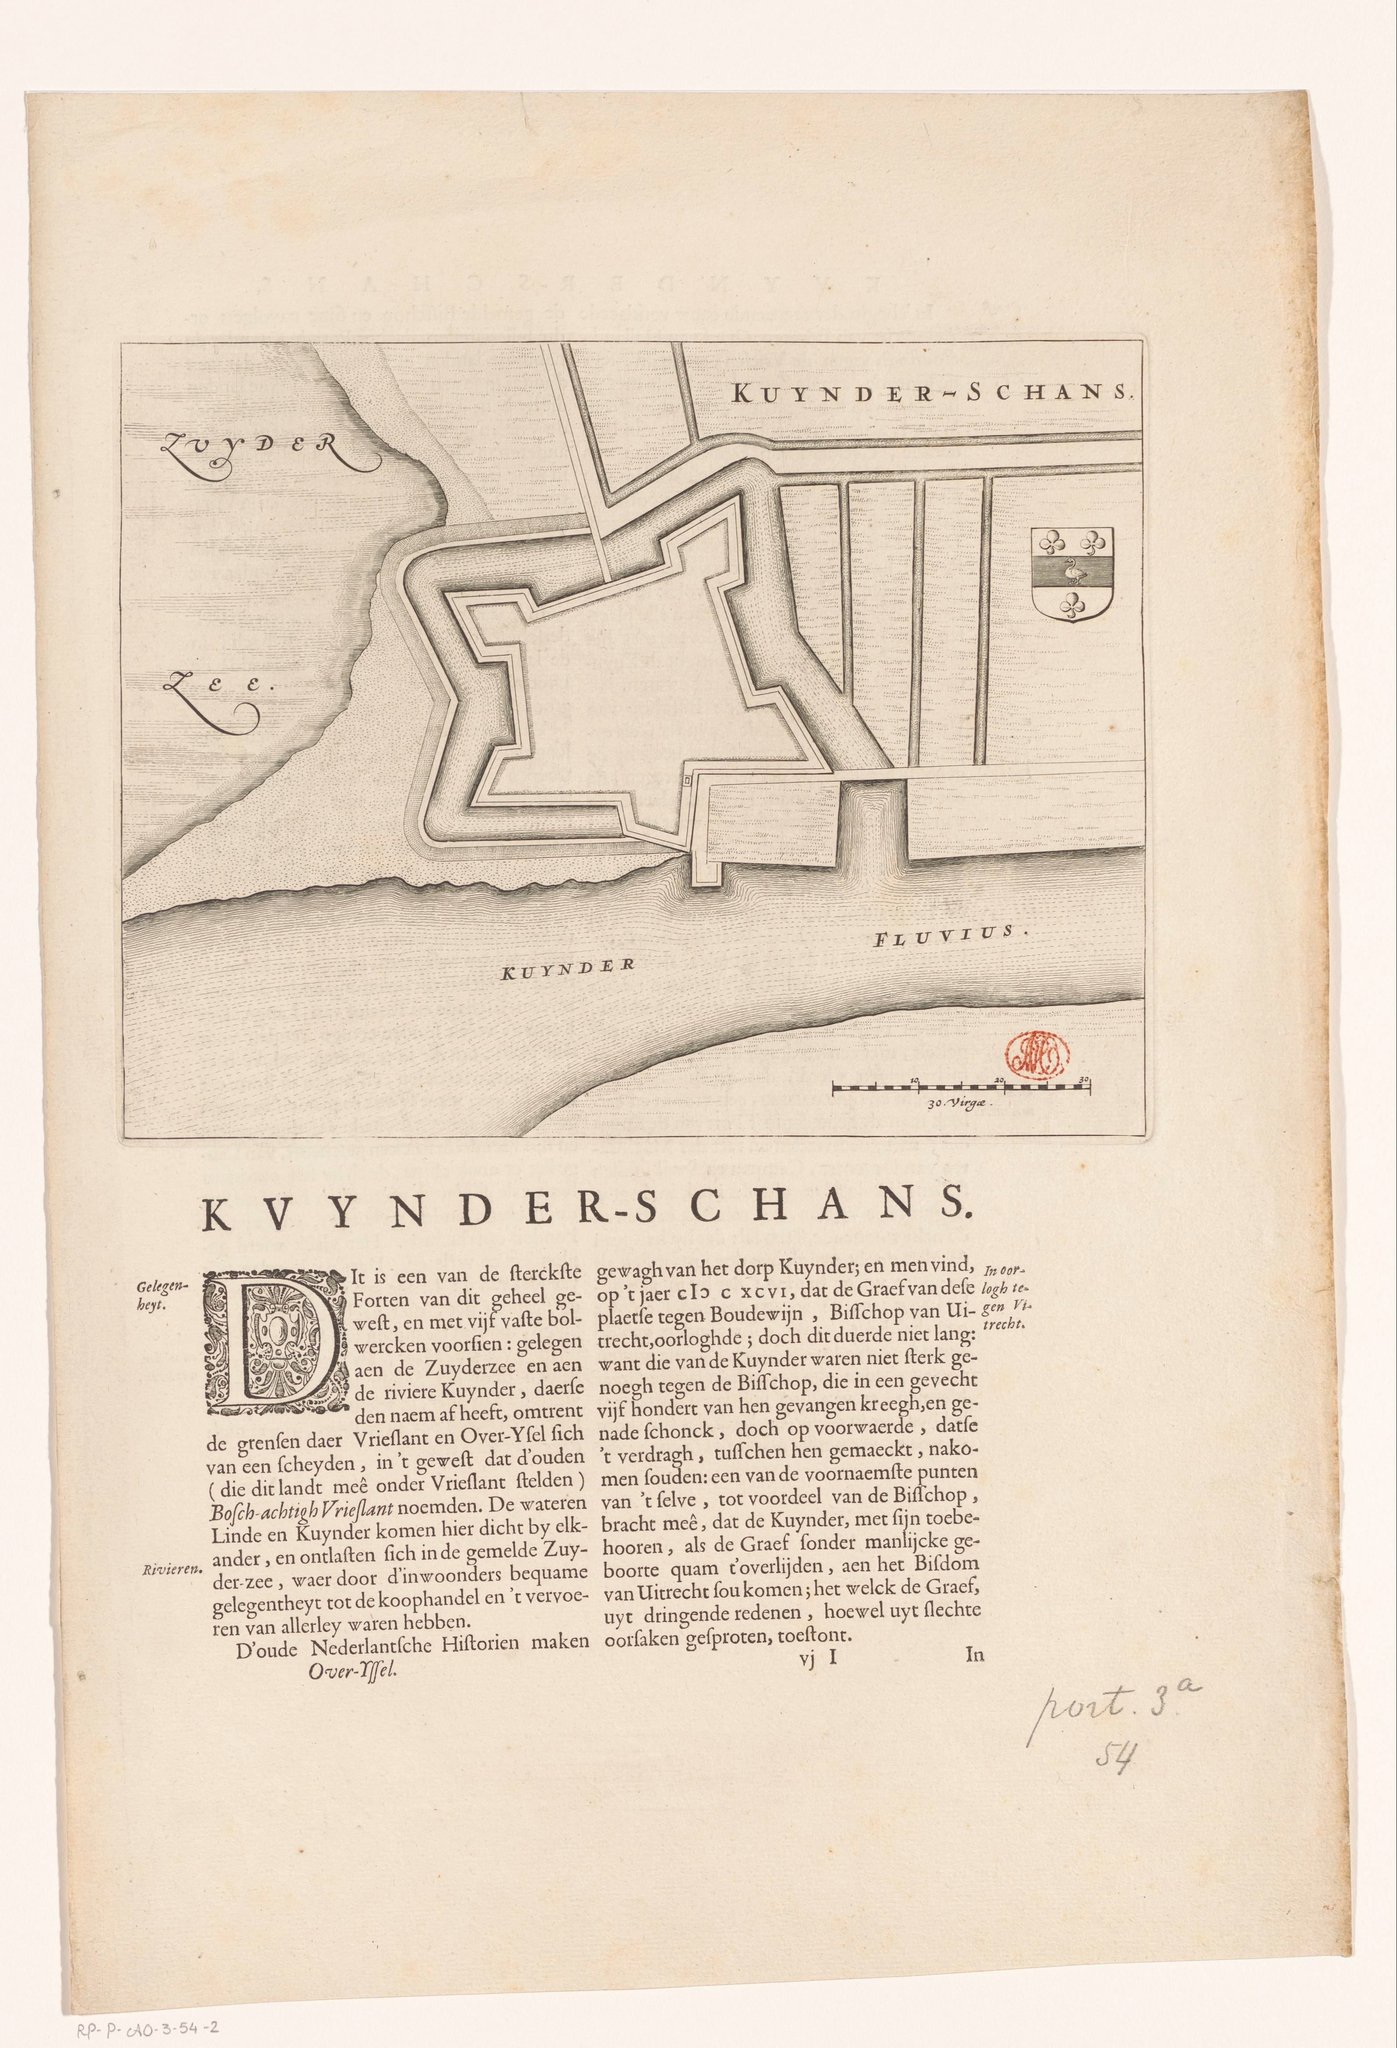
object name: print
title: Vestingplattegrond van Kuinre met beschrijving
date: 1652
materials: paper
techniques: engraving, etching, letterpress printing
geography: amsterdam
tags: fortress, coat of arms (as symbol of the state, etc.), maps of cities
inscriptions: collector's mark: Lugt 195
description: Prent gebruikt in: Blaeu, Johannes Willemszoon. Toonneel der steden van de Vereenighde Nederlanden. 2 delen. Amsterdam: Johannes Willemszoon Blaeu, 1652, dl. 1.